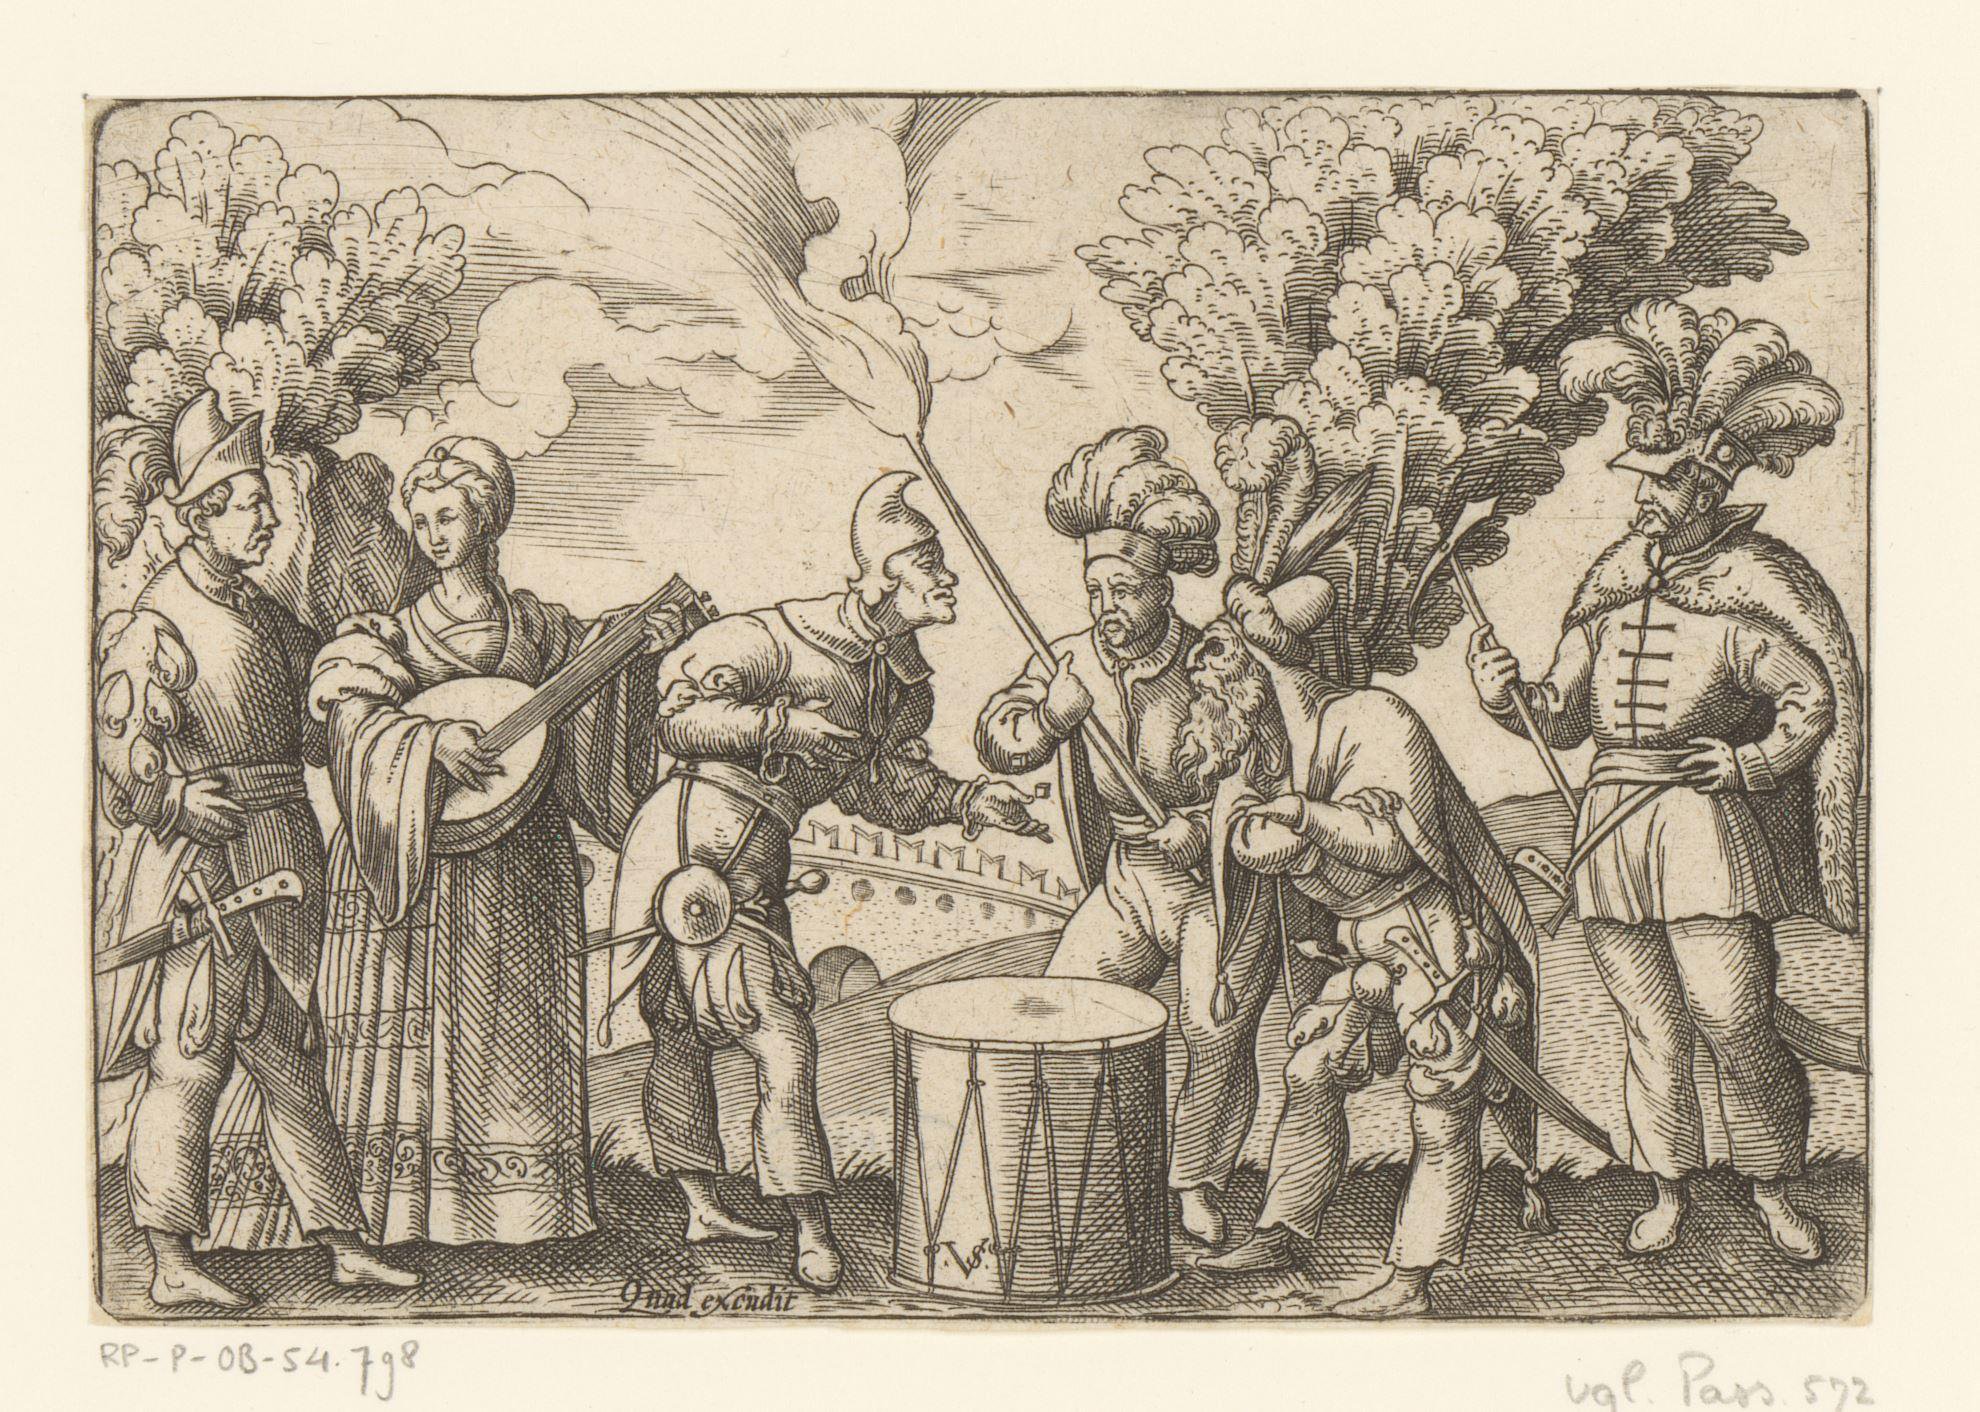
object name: print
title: Zes figuren rondom een trommel, mogelijk Vastenavond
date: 1524-1562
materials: paper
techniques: engraving, etching, intaglio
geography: nuremberg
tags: carnival, shrovetide (non-liturgical celebration), drum (musical instrument) - cc - out of doors, shrove tuesday, 'mardi gras' ~ non-liturgical celebrations of carnival, lute, and special forms of lute, e.g.: theorbo - cc - out of doors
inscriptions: number: ‘104’, collector's mark: Lugt 2228